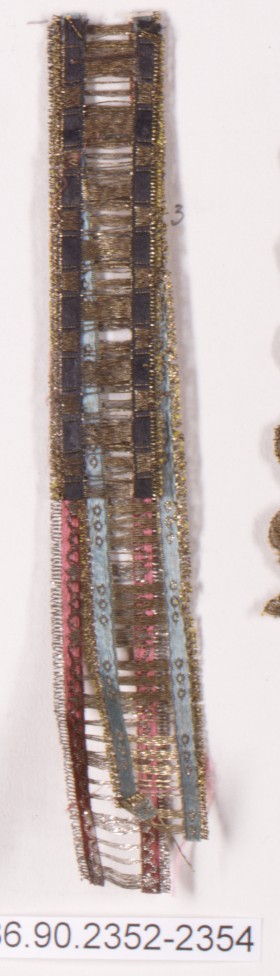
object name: ribbon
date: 1801-1900